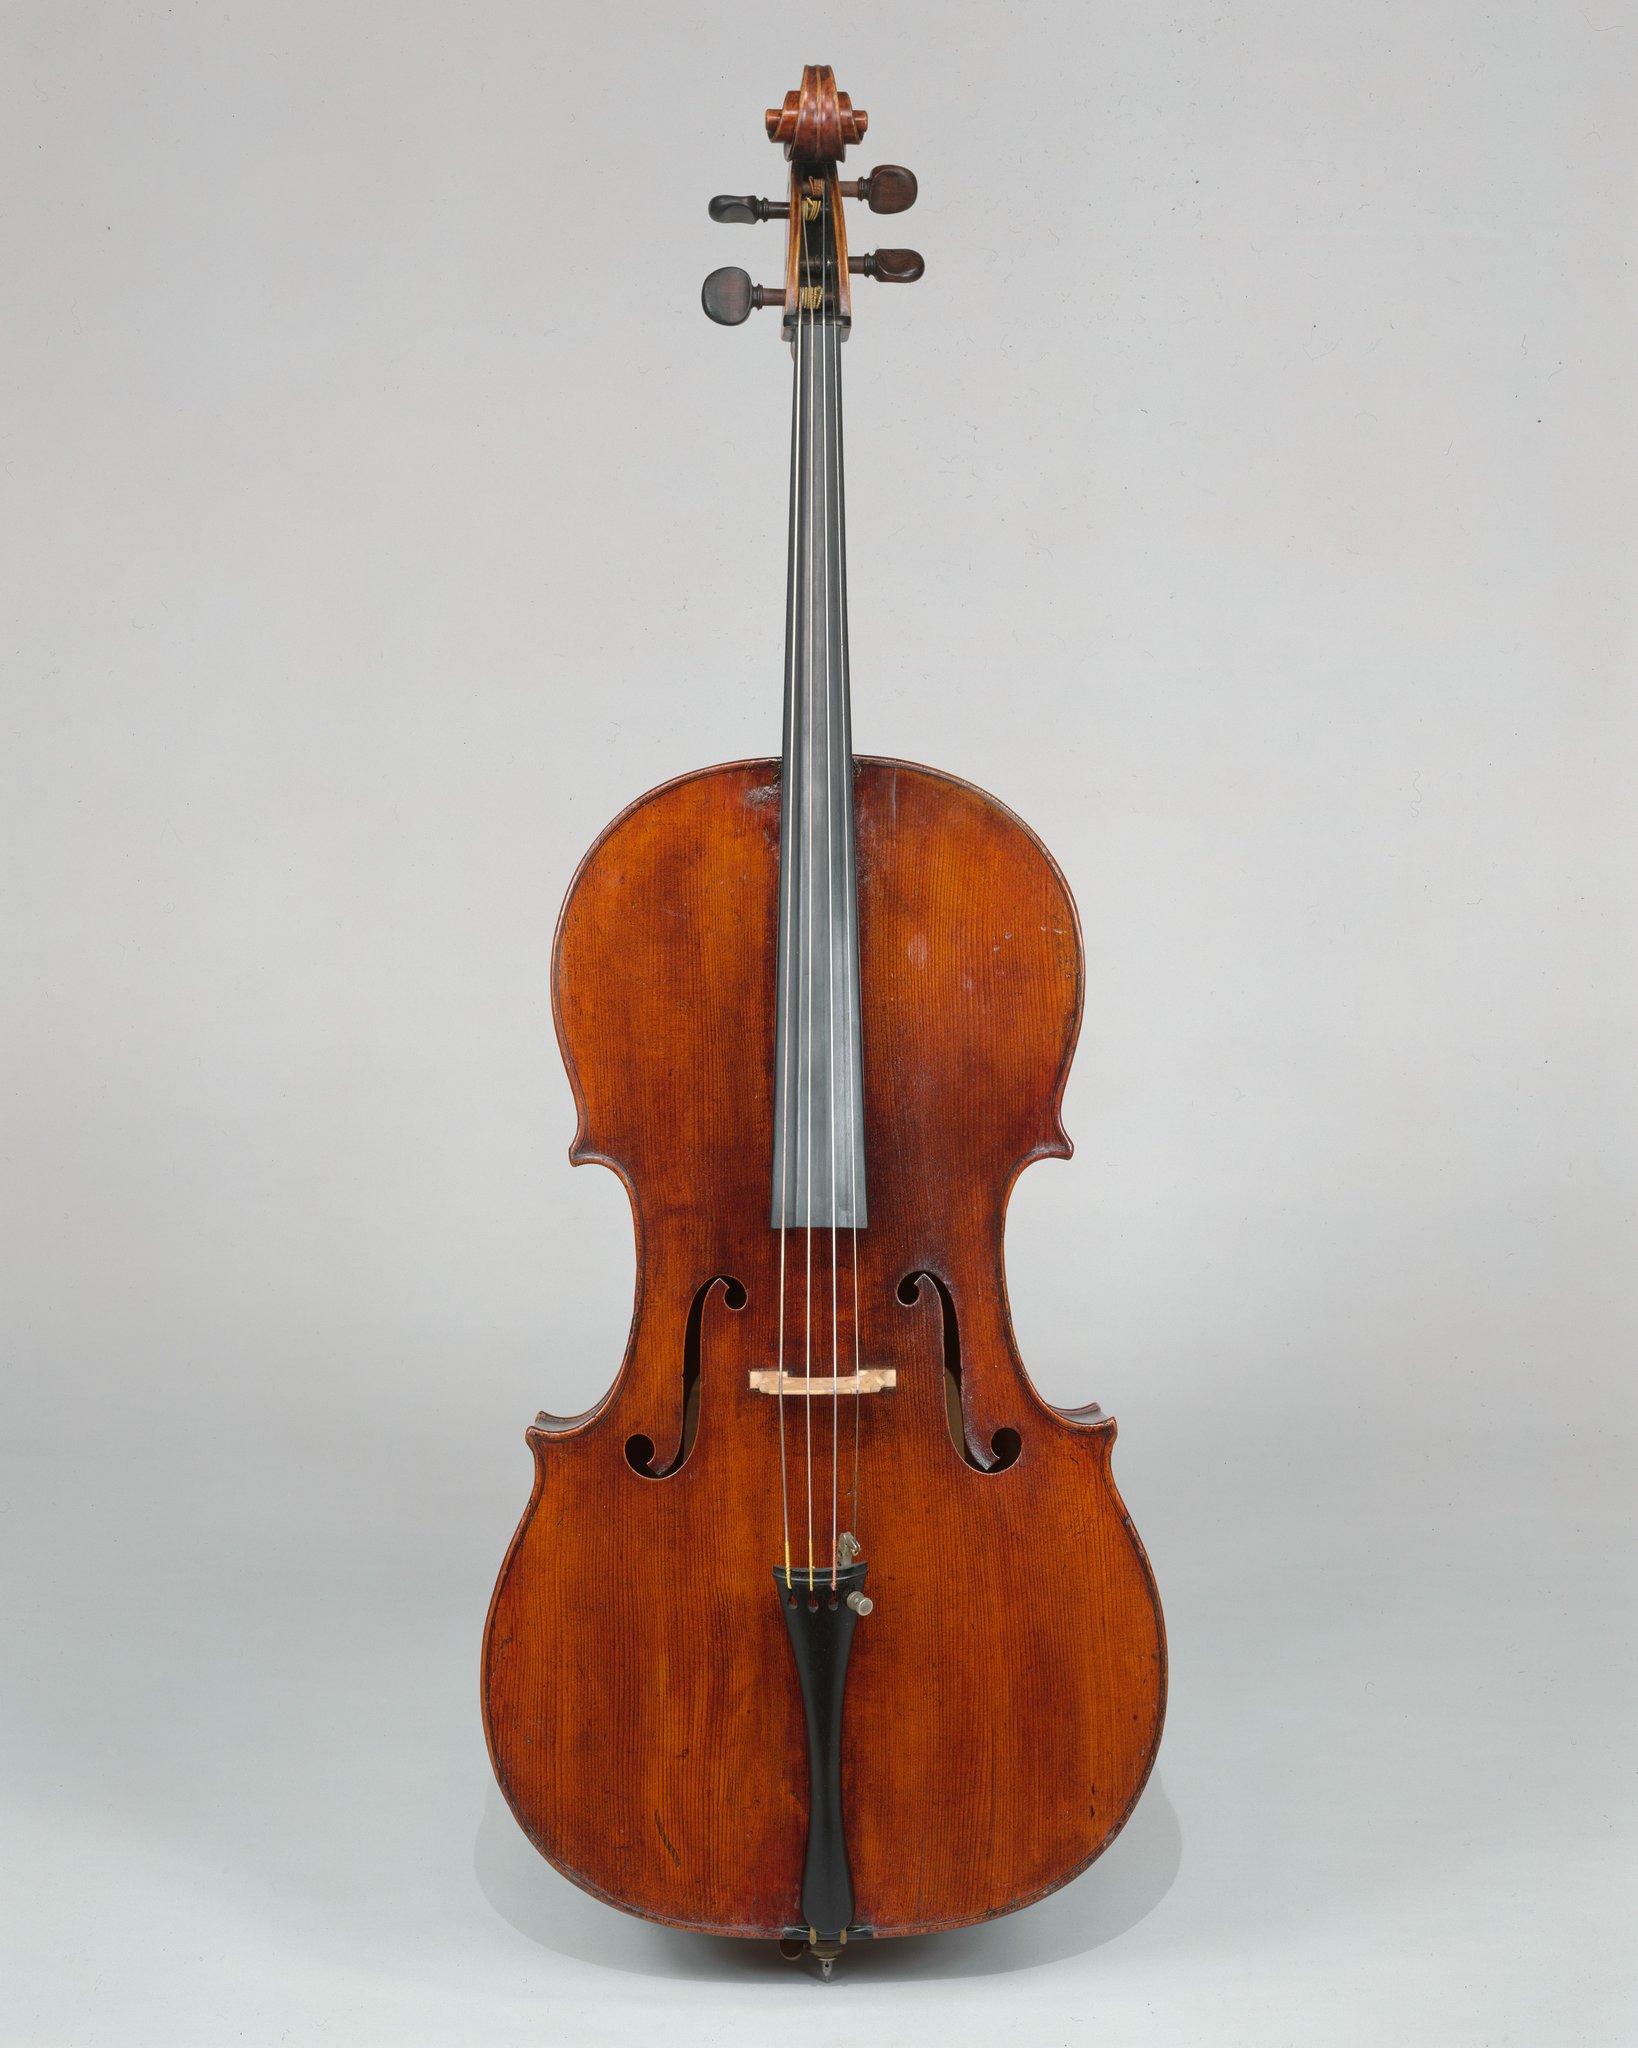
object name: violoncello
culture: french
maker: jean baptiste vuillaume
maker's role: maker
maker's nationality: french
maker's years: 1798-1875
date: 1834-1866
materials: wood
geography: france